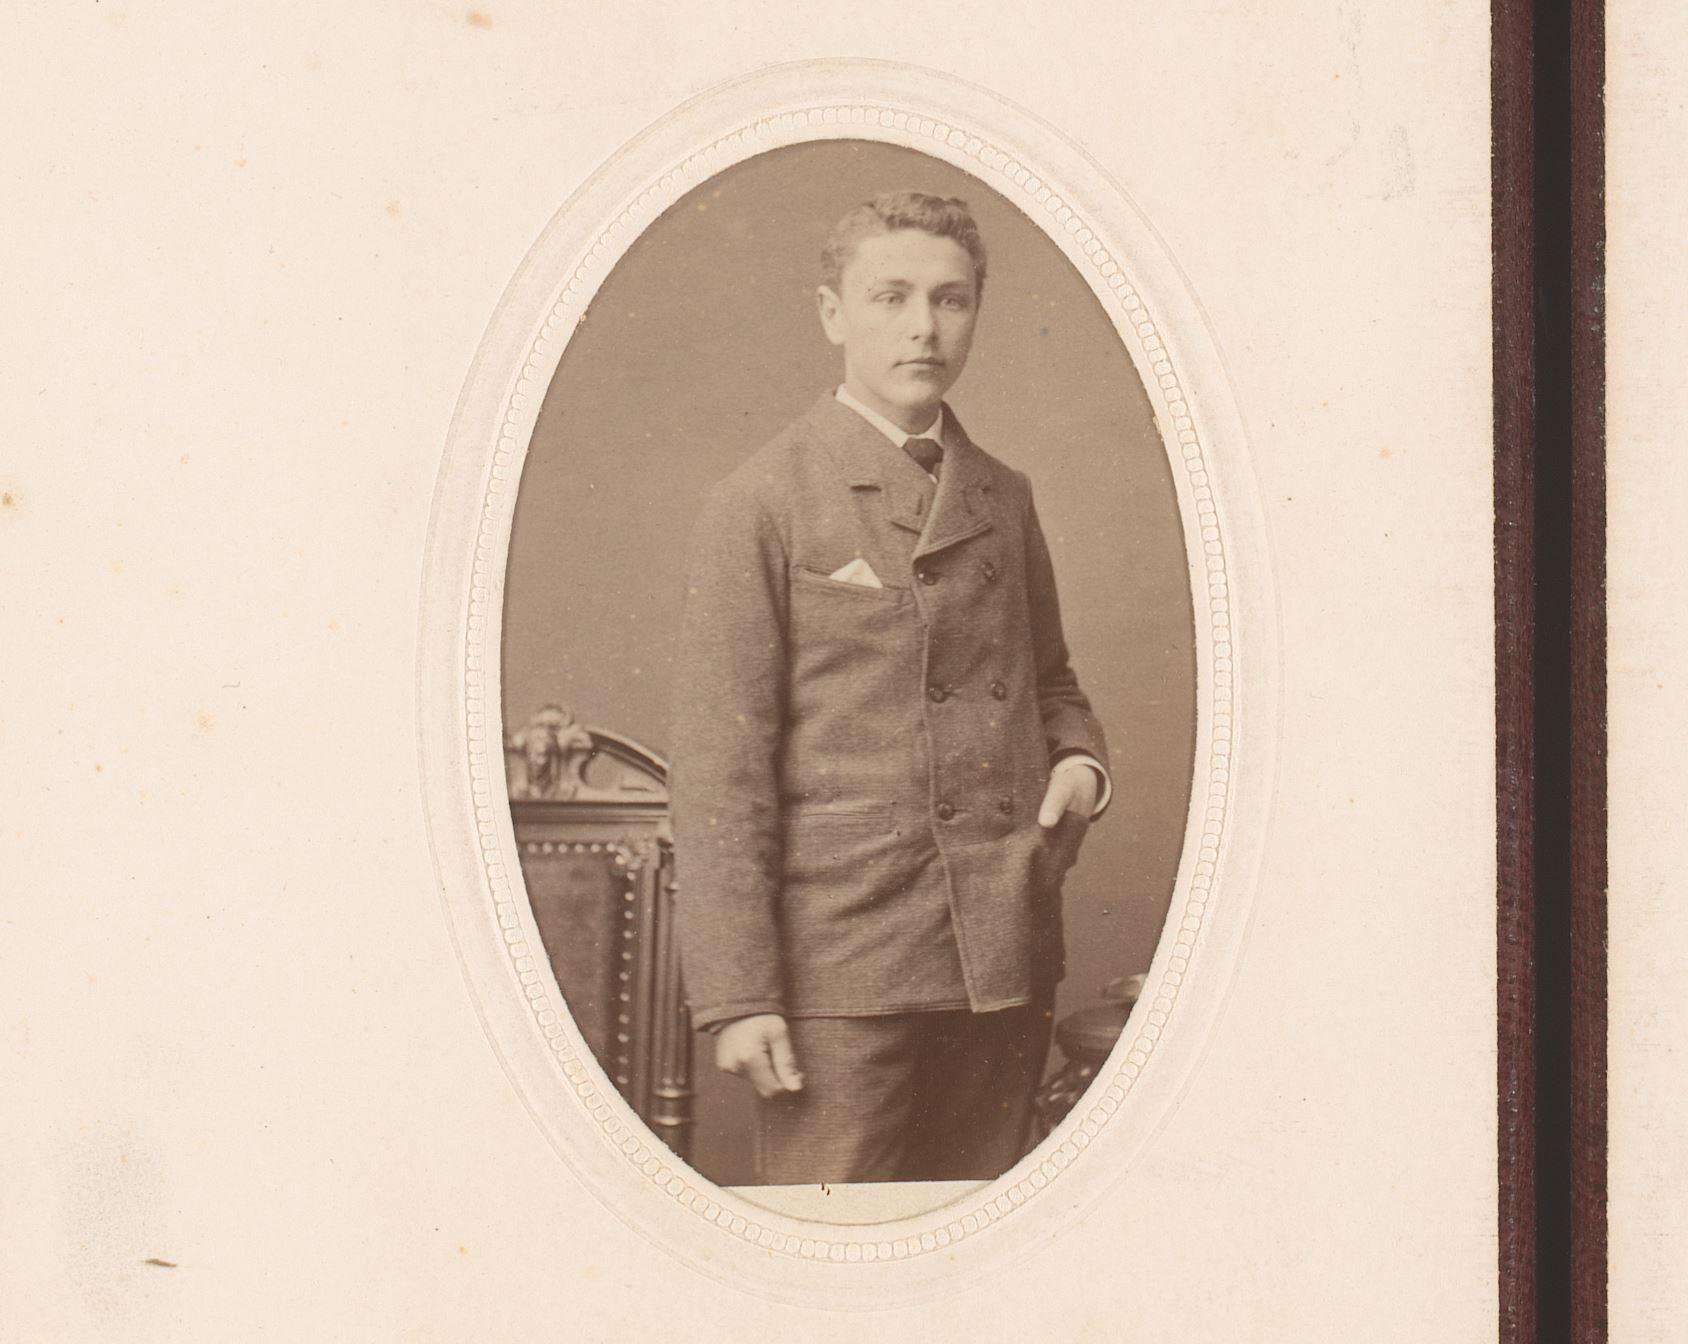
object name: album leaf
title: Portret van een staande jonge man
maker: albert greiner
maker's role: fotograaf, fotostudio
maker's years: 1833-1890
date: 1861-1887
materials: cardboard, paper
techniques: albumen print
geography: amsterdam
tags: standing figure, historical persons, youth, adolescent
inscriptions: number: ‘642A’, inscription: ‘(...)/ Photograaf/ van/ HH: MM:/ DEN KONING/ en/ KONINGIN/ der Nederlanden./ A. GREINER/ AMSTERDAM/ Nieuwendijk, L. 89.’